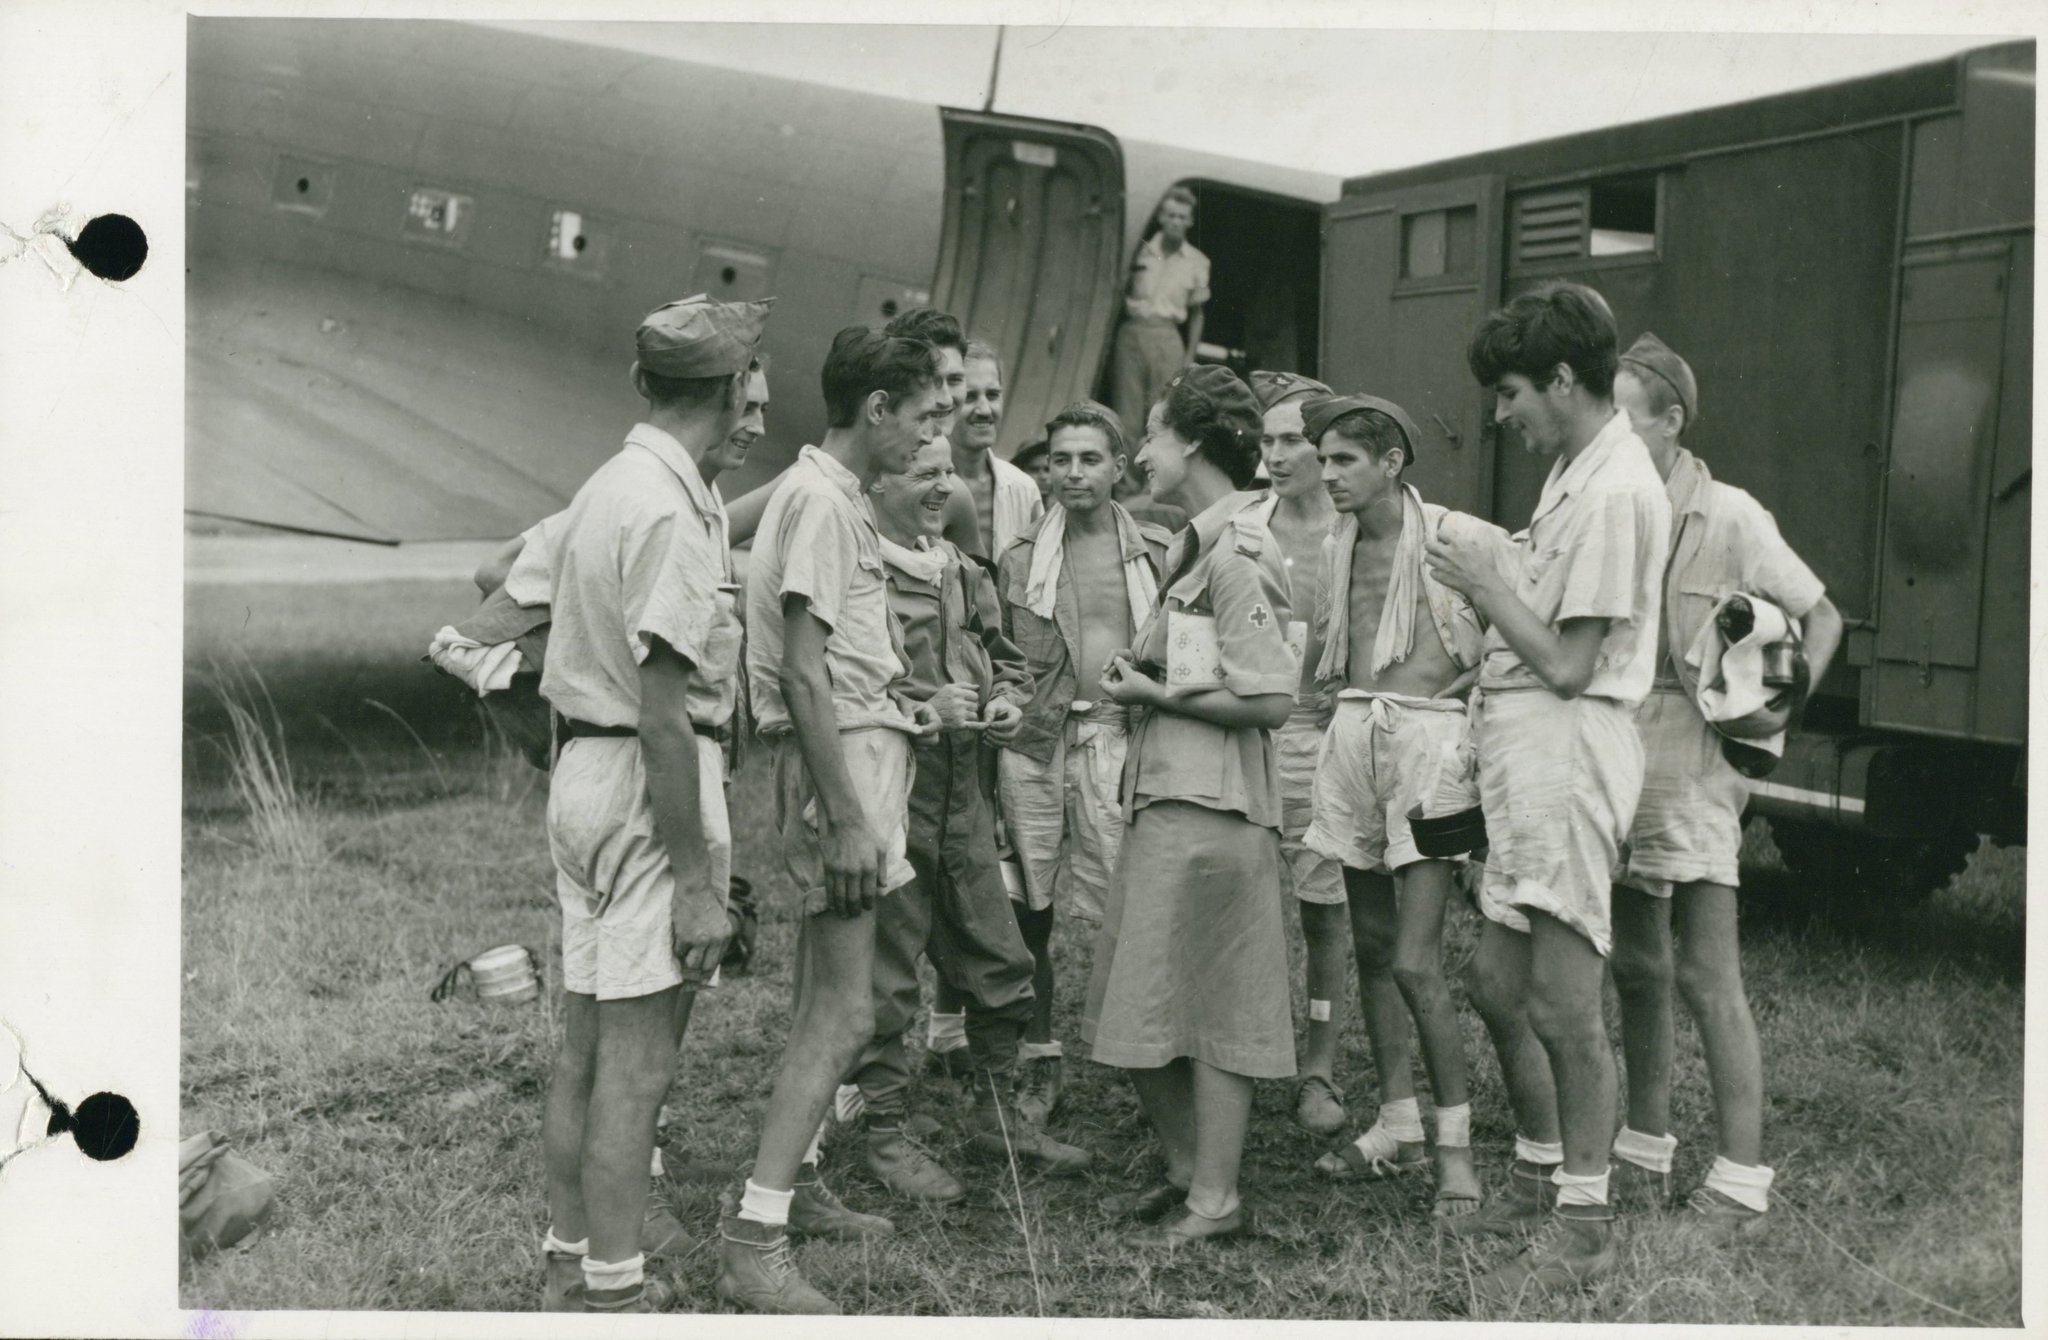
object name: documentary photograph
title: Nederlandse geïnterneerden arriveren veilig in Singapore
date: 1909-1945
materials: photographic support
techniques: photography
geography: singapore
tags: publisher, singapore, dutch east indies, the, indonesia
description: Een twaalftal breed lachende mannen in korte broeken staat gegroepeerd rond een inspectrice van het Rode Kruis. Op de achtergrond het vliegtuig waarmee ze zojuist geland zijn op de Civil Aerodrome in Singapore.